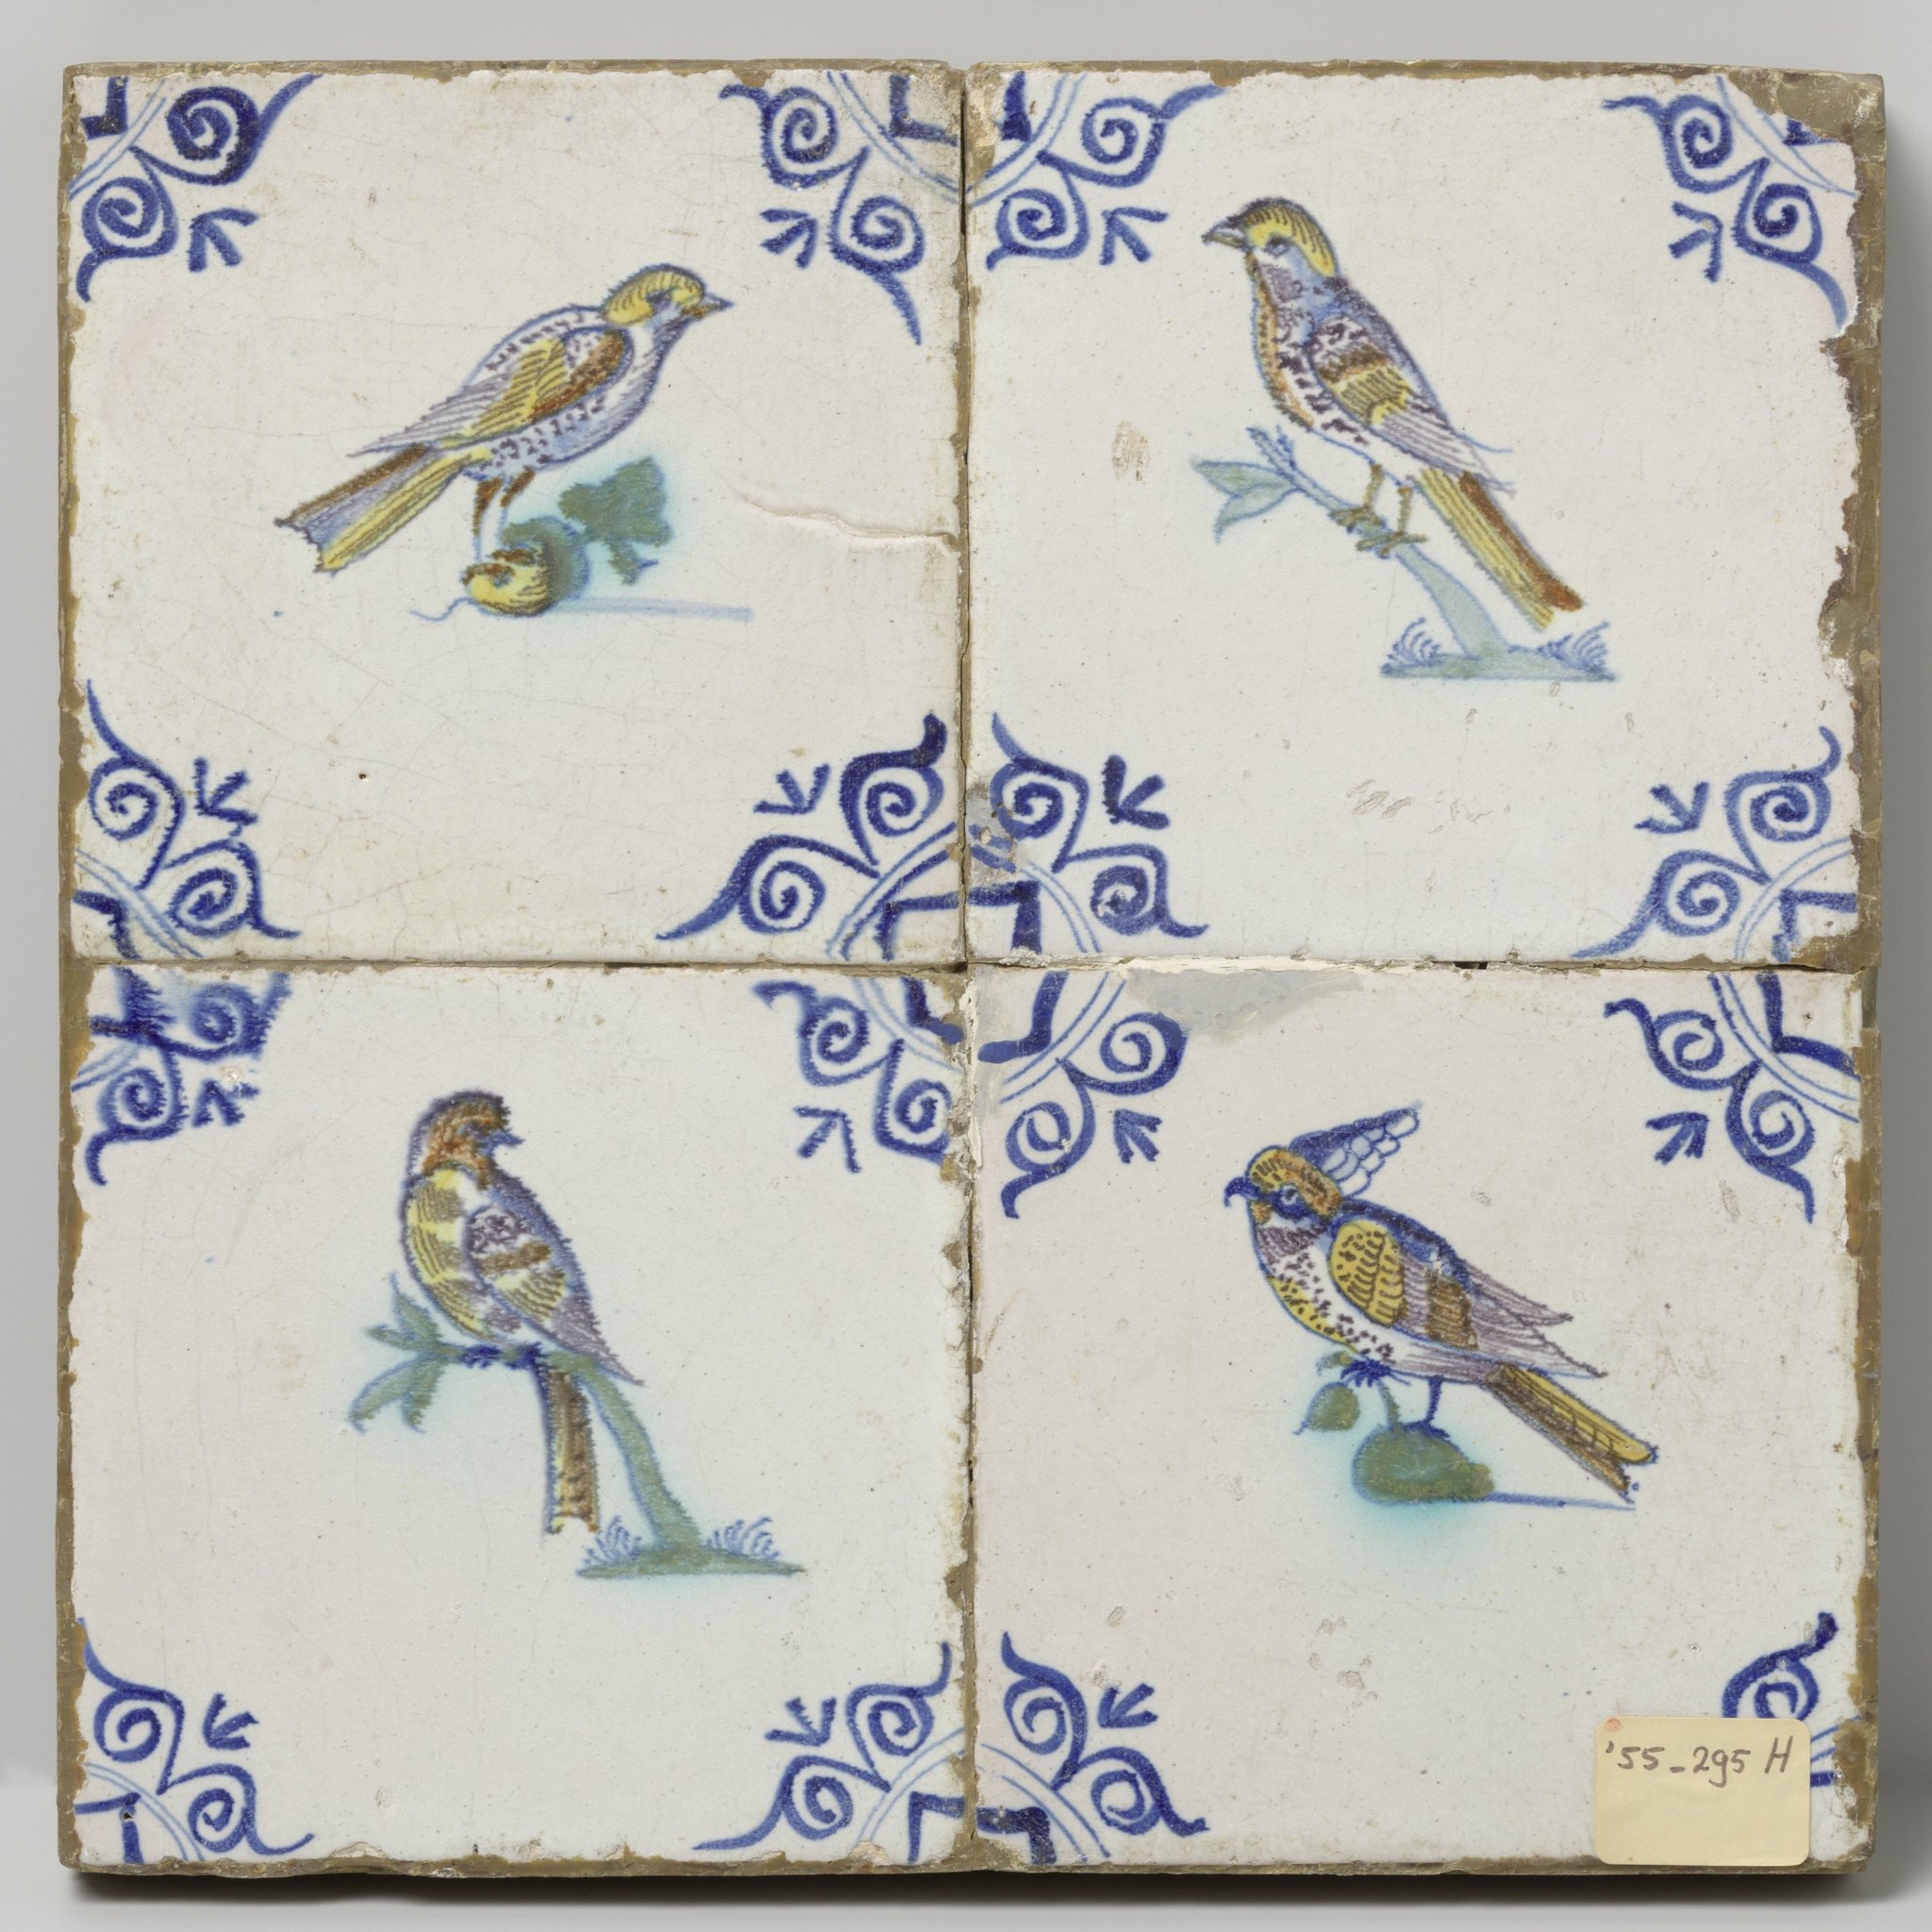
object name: tile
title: Veld van vier tegels met vogels op takken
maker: Anonymous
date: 1640-1660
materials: earthenware, glaze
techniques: maiolica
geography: netherlands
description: Veld van vier tegels (2 x 2) elk met een veelkleurige (blauw, groen, geel, oranje en paars) vogel op een tak. In de hoeken, een ossekop.